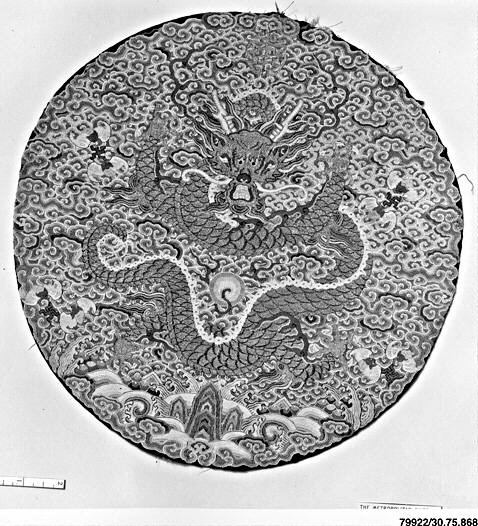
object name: medallion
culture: chinese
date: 1701-1800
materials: metal thread, silk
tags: dragons